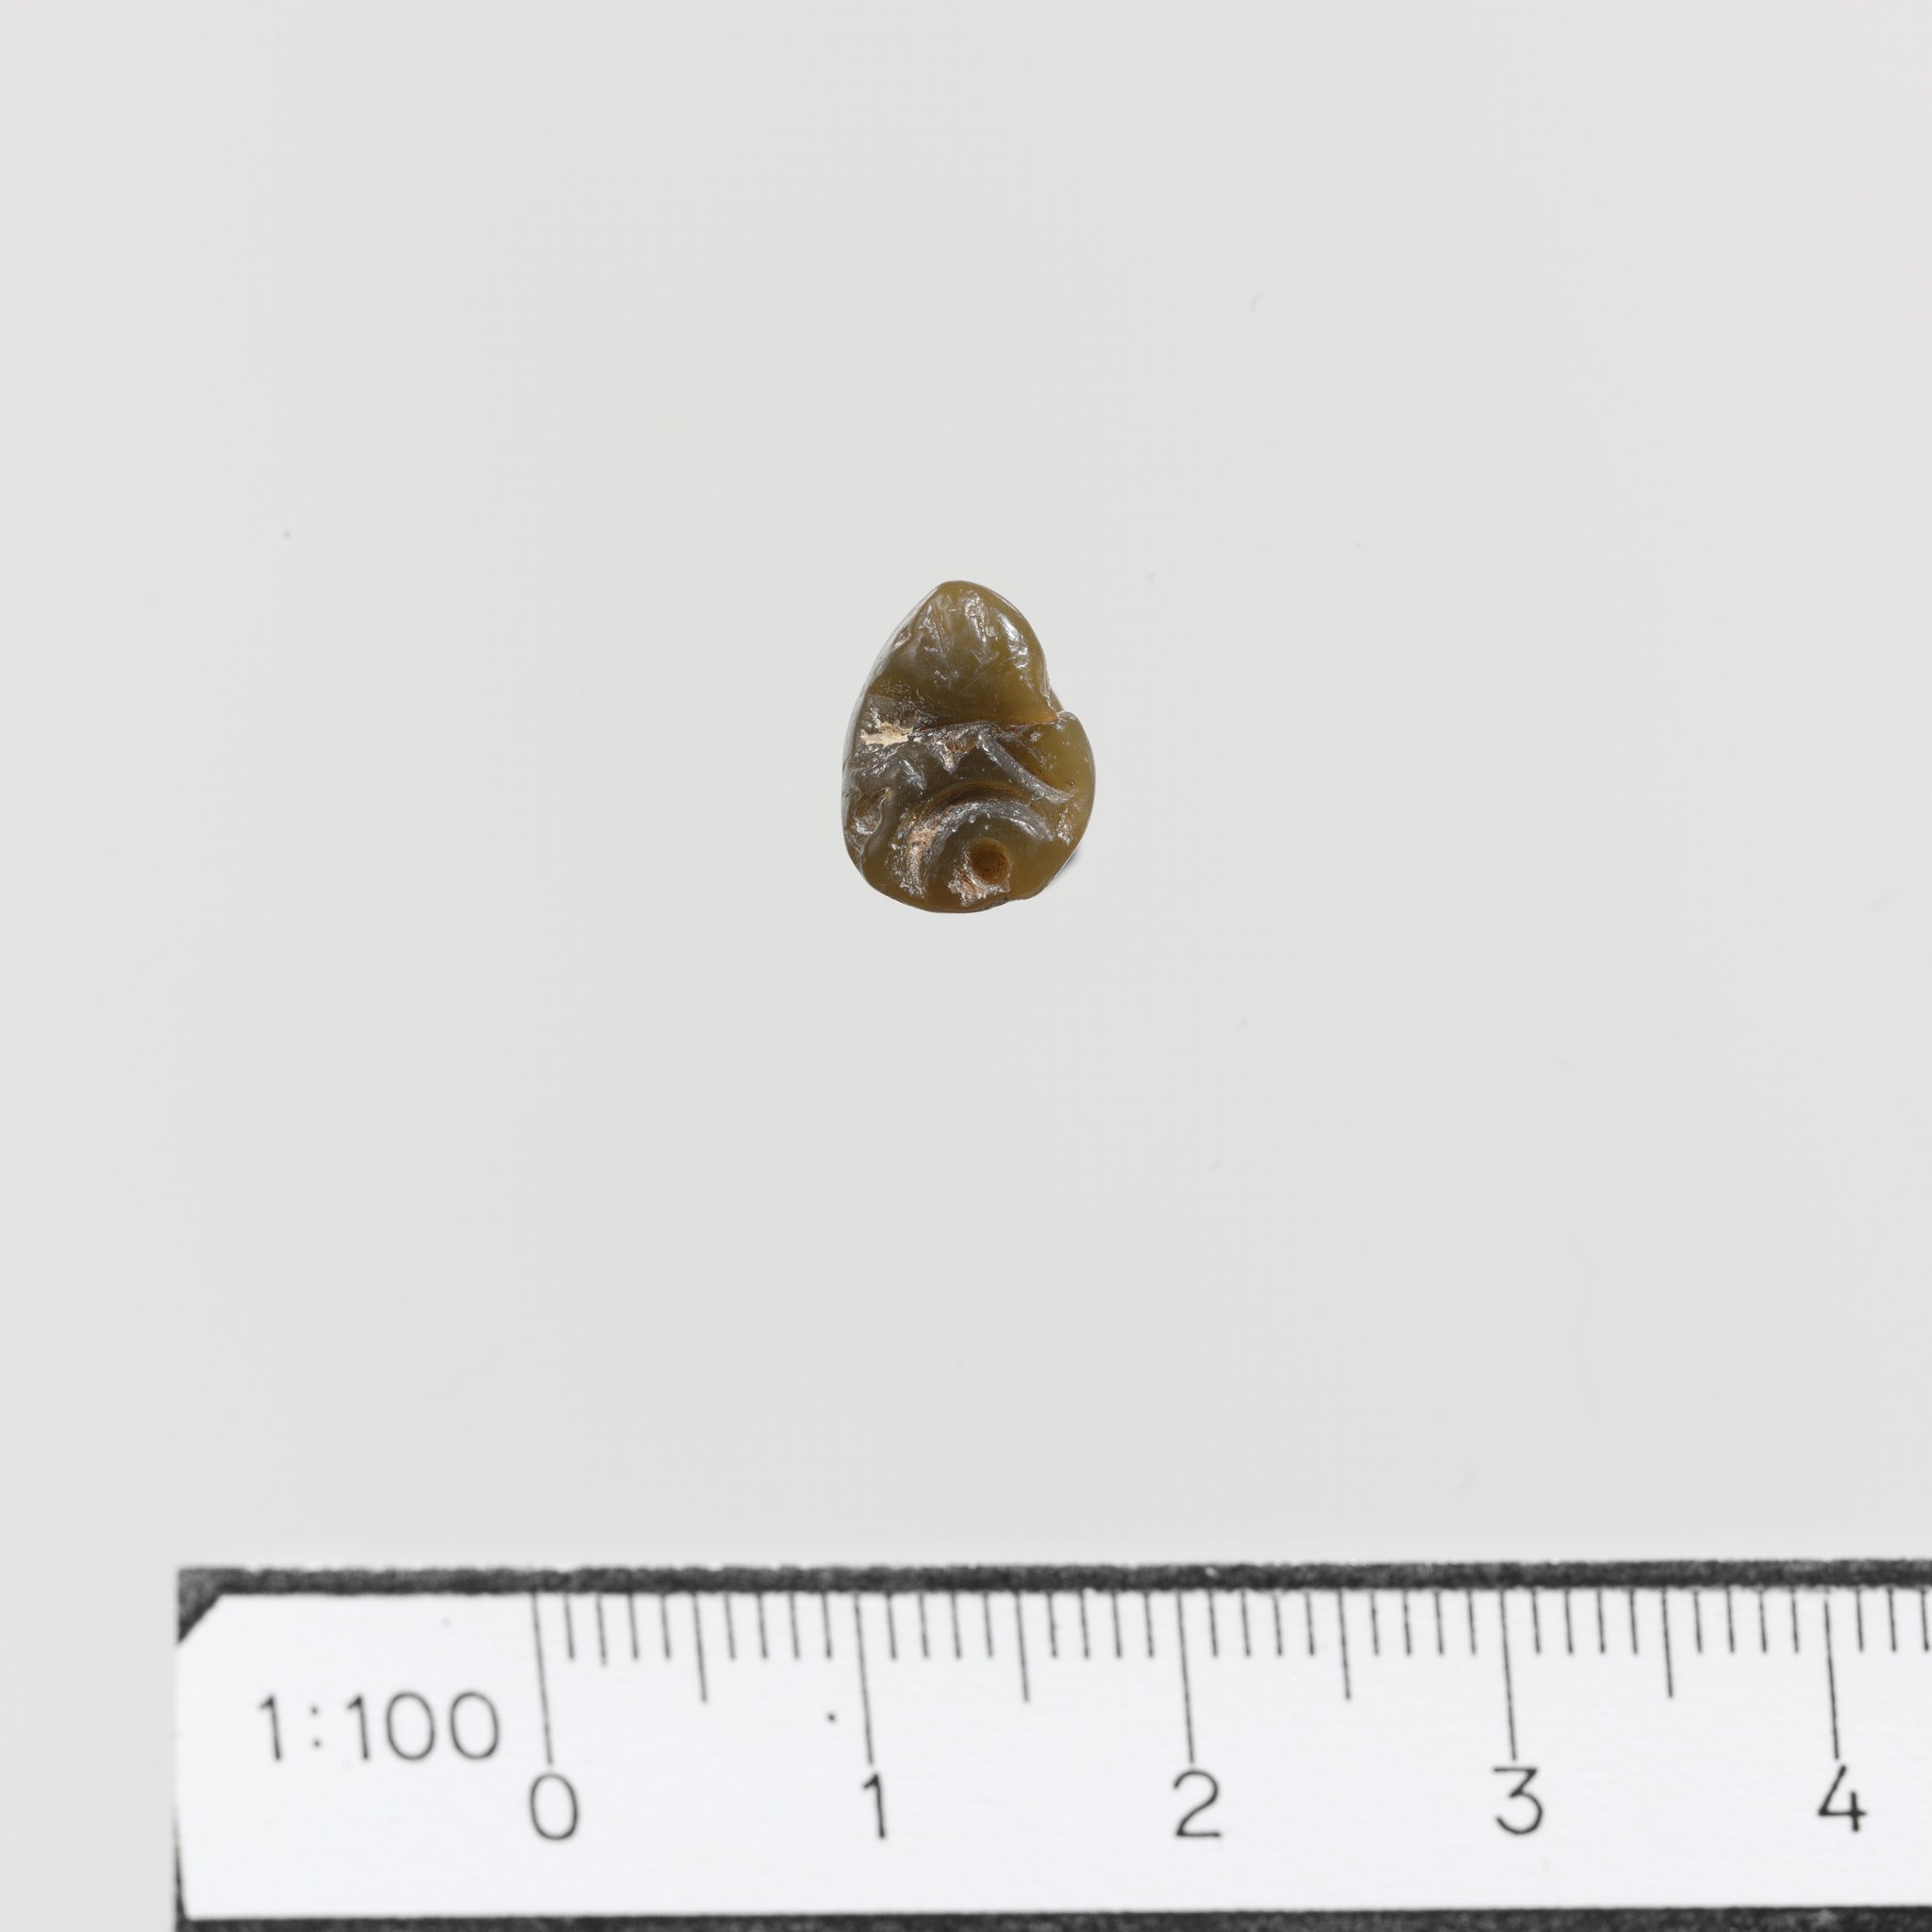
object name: seal, loop handled signet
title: Seal, loop-handled signet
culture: minoan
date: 1800-1700 BCE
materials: stone